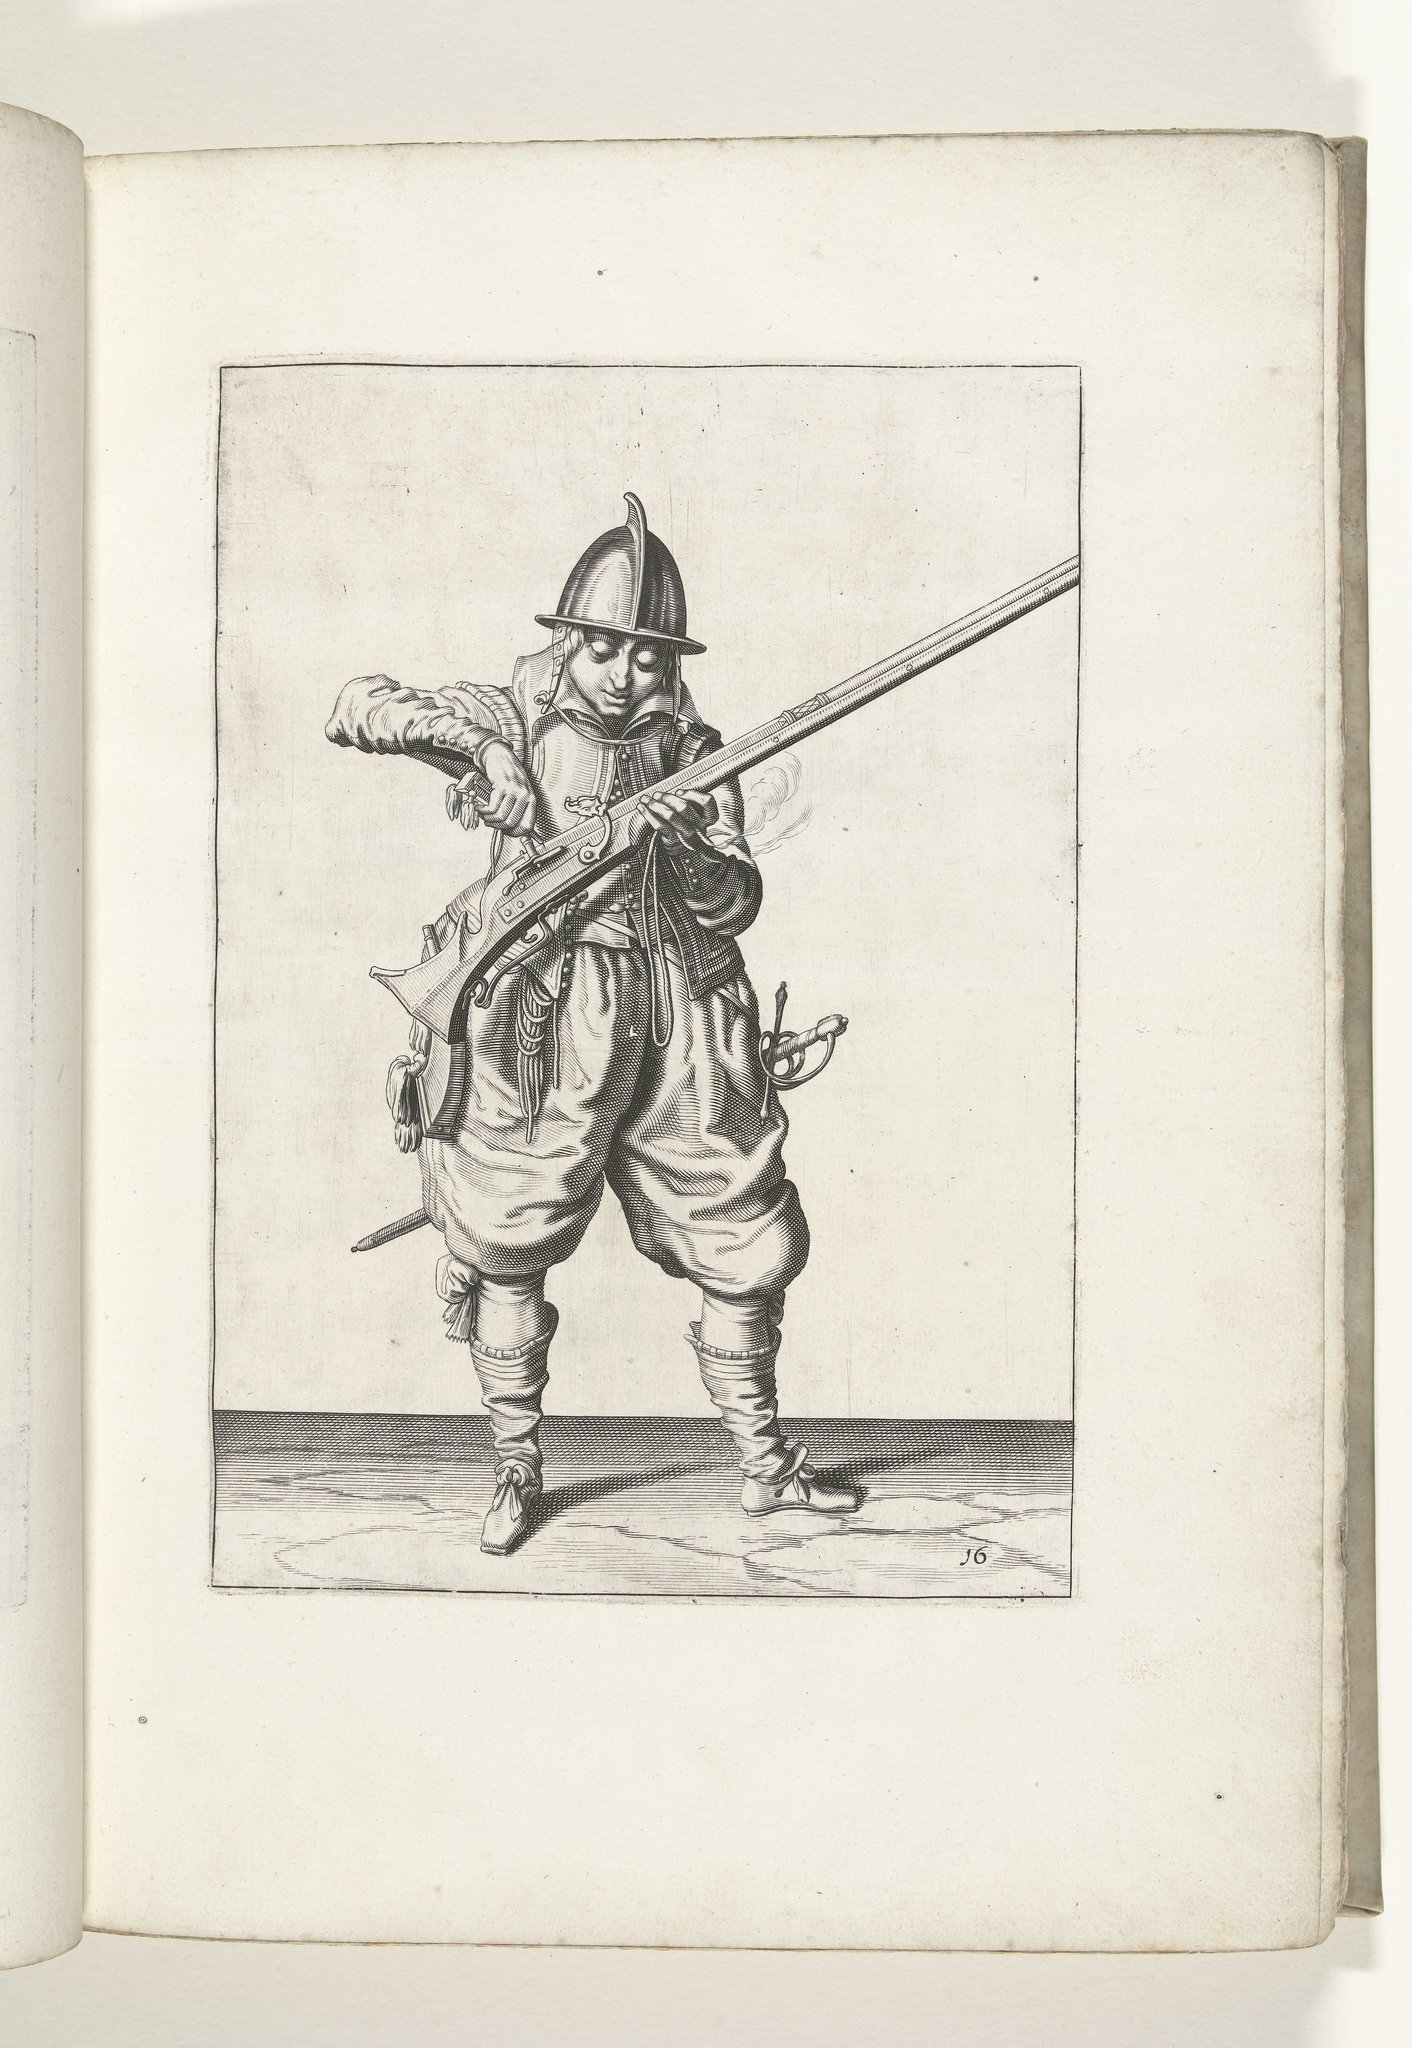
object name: print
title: Soldaat die kruit in de pan van zijn roer giet (nr. 16), ca. 1600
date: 1597-1607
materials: paper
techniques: engraving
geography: the hague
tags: maurice (prince of orange), handling of weapons ~ military training, weapons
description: Een soldaat, ten voeten uit, die kruit uit een kruitfles in de pan (het kruitreservoir) van een roer (een bepaald type vuurwapen) giet (nr. 16), ca. 1600. In zijn linkerhand behalve het roer ook een brandende lont. Plaat 16 in de instructies voor het hanteren van de roer: Corte onderwysinghe op de figuerliicke afbeeldinghe, belanghende t'rechte ghebruyck des Roers. Onderdeel van de illustraties in: J. de Gheyn, Wapenhandelinghe van Roers Musquetten ende spiessen, 's-Gravenhage, 1607. Krijgswezen rond 1600.